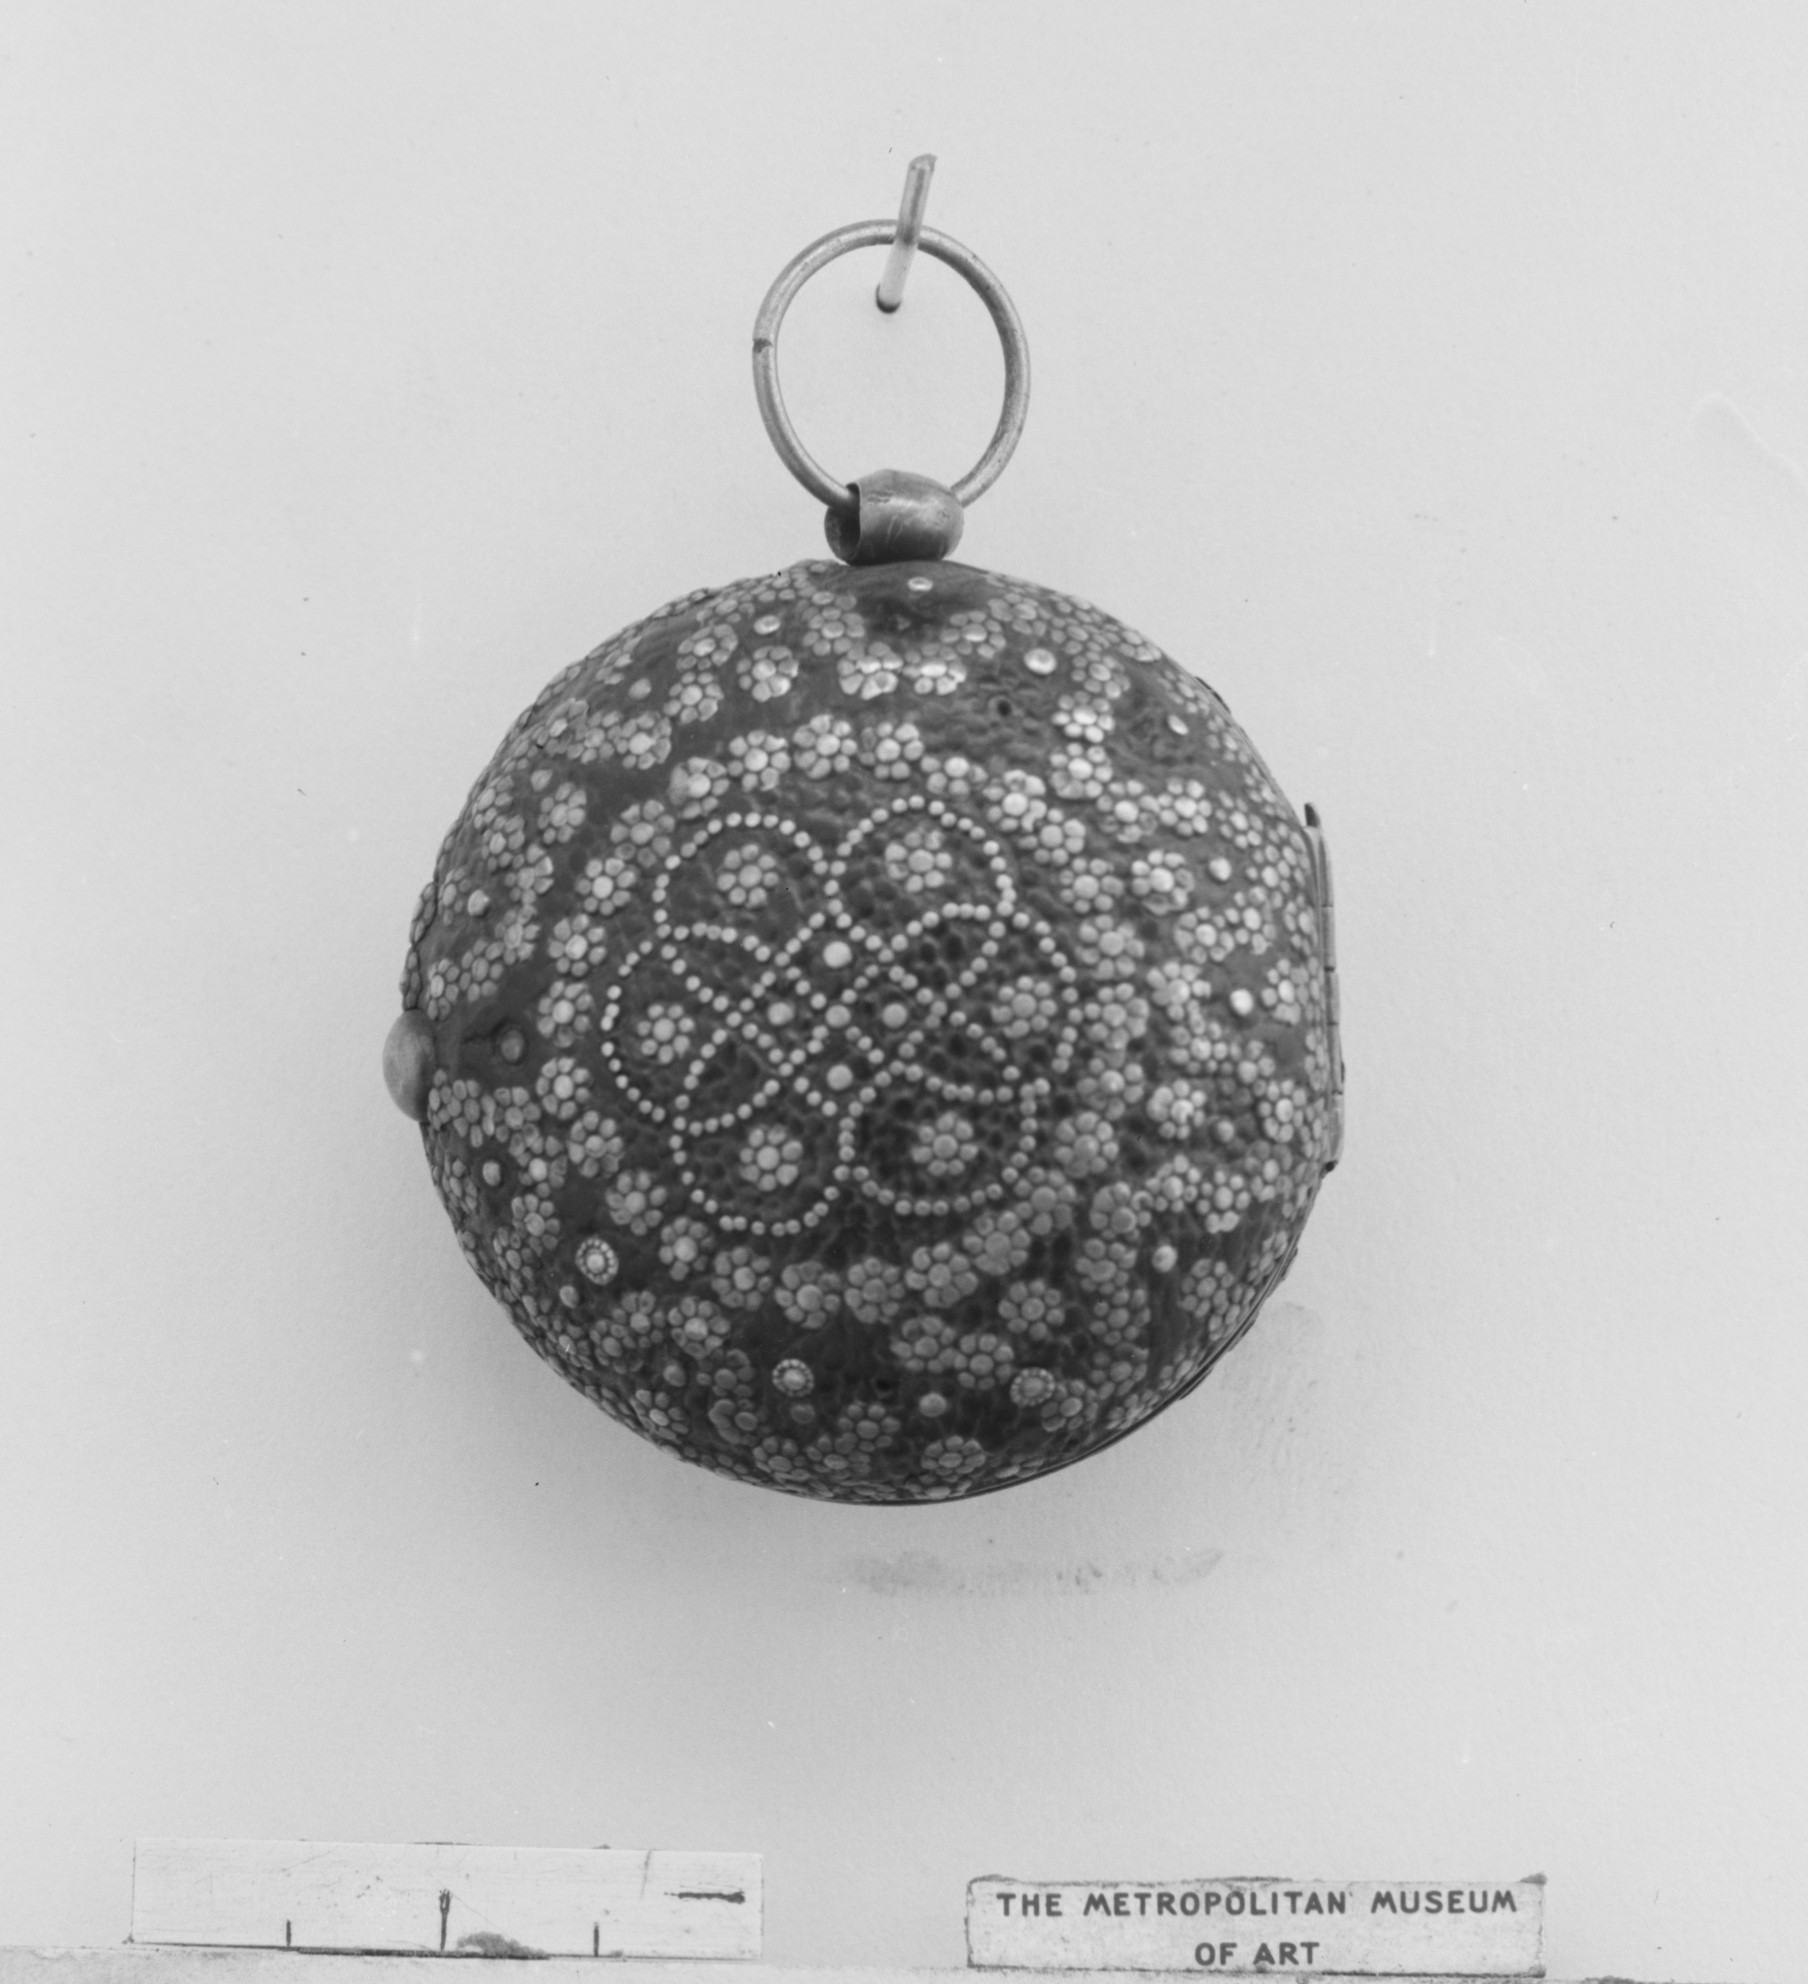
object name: watch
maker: paul roumieu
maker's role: maker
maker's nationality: french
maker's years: 1594-1694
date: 1630-1670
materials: enamel, leather, silver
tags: flowers